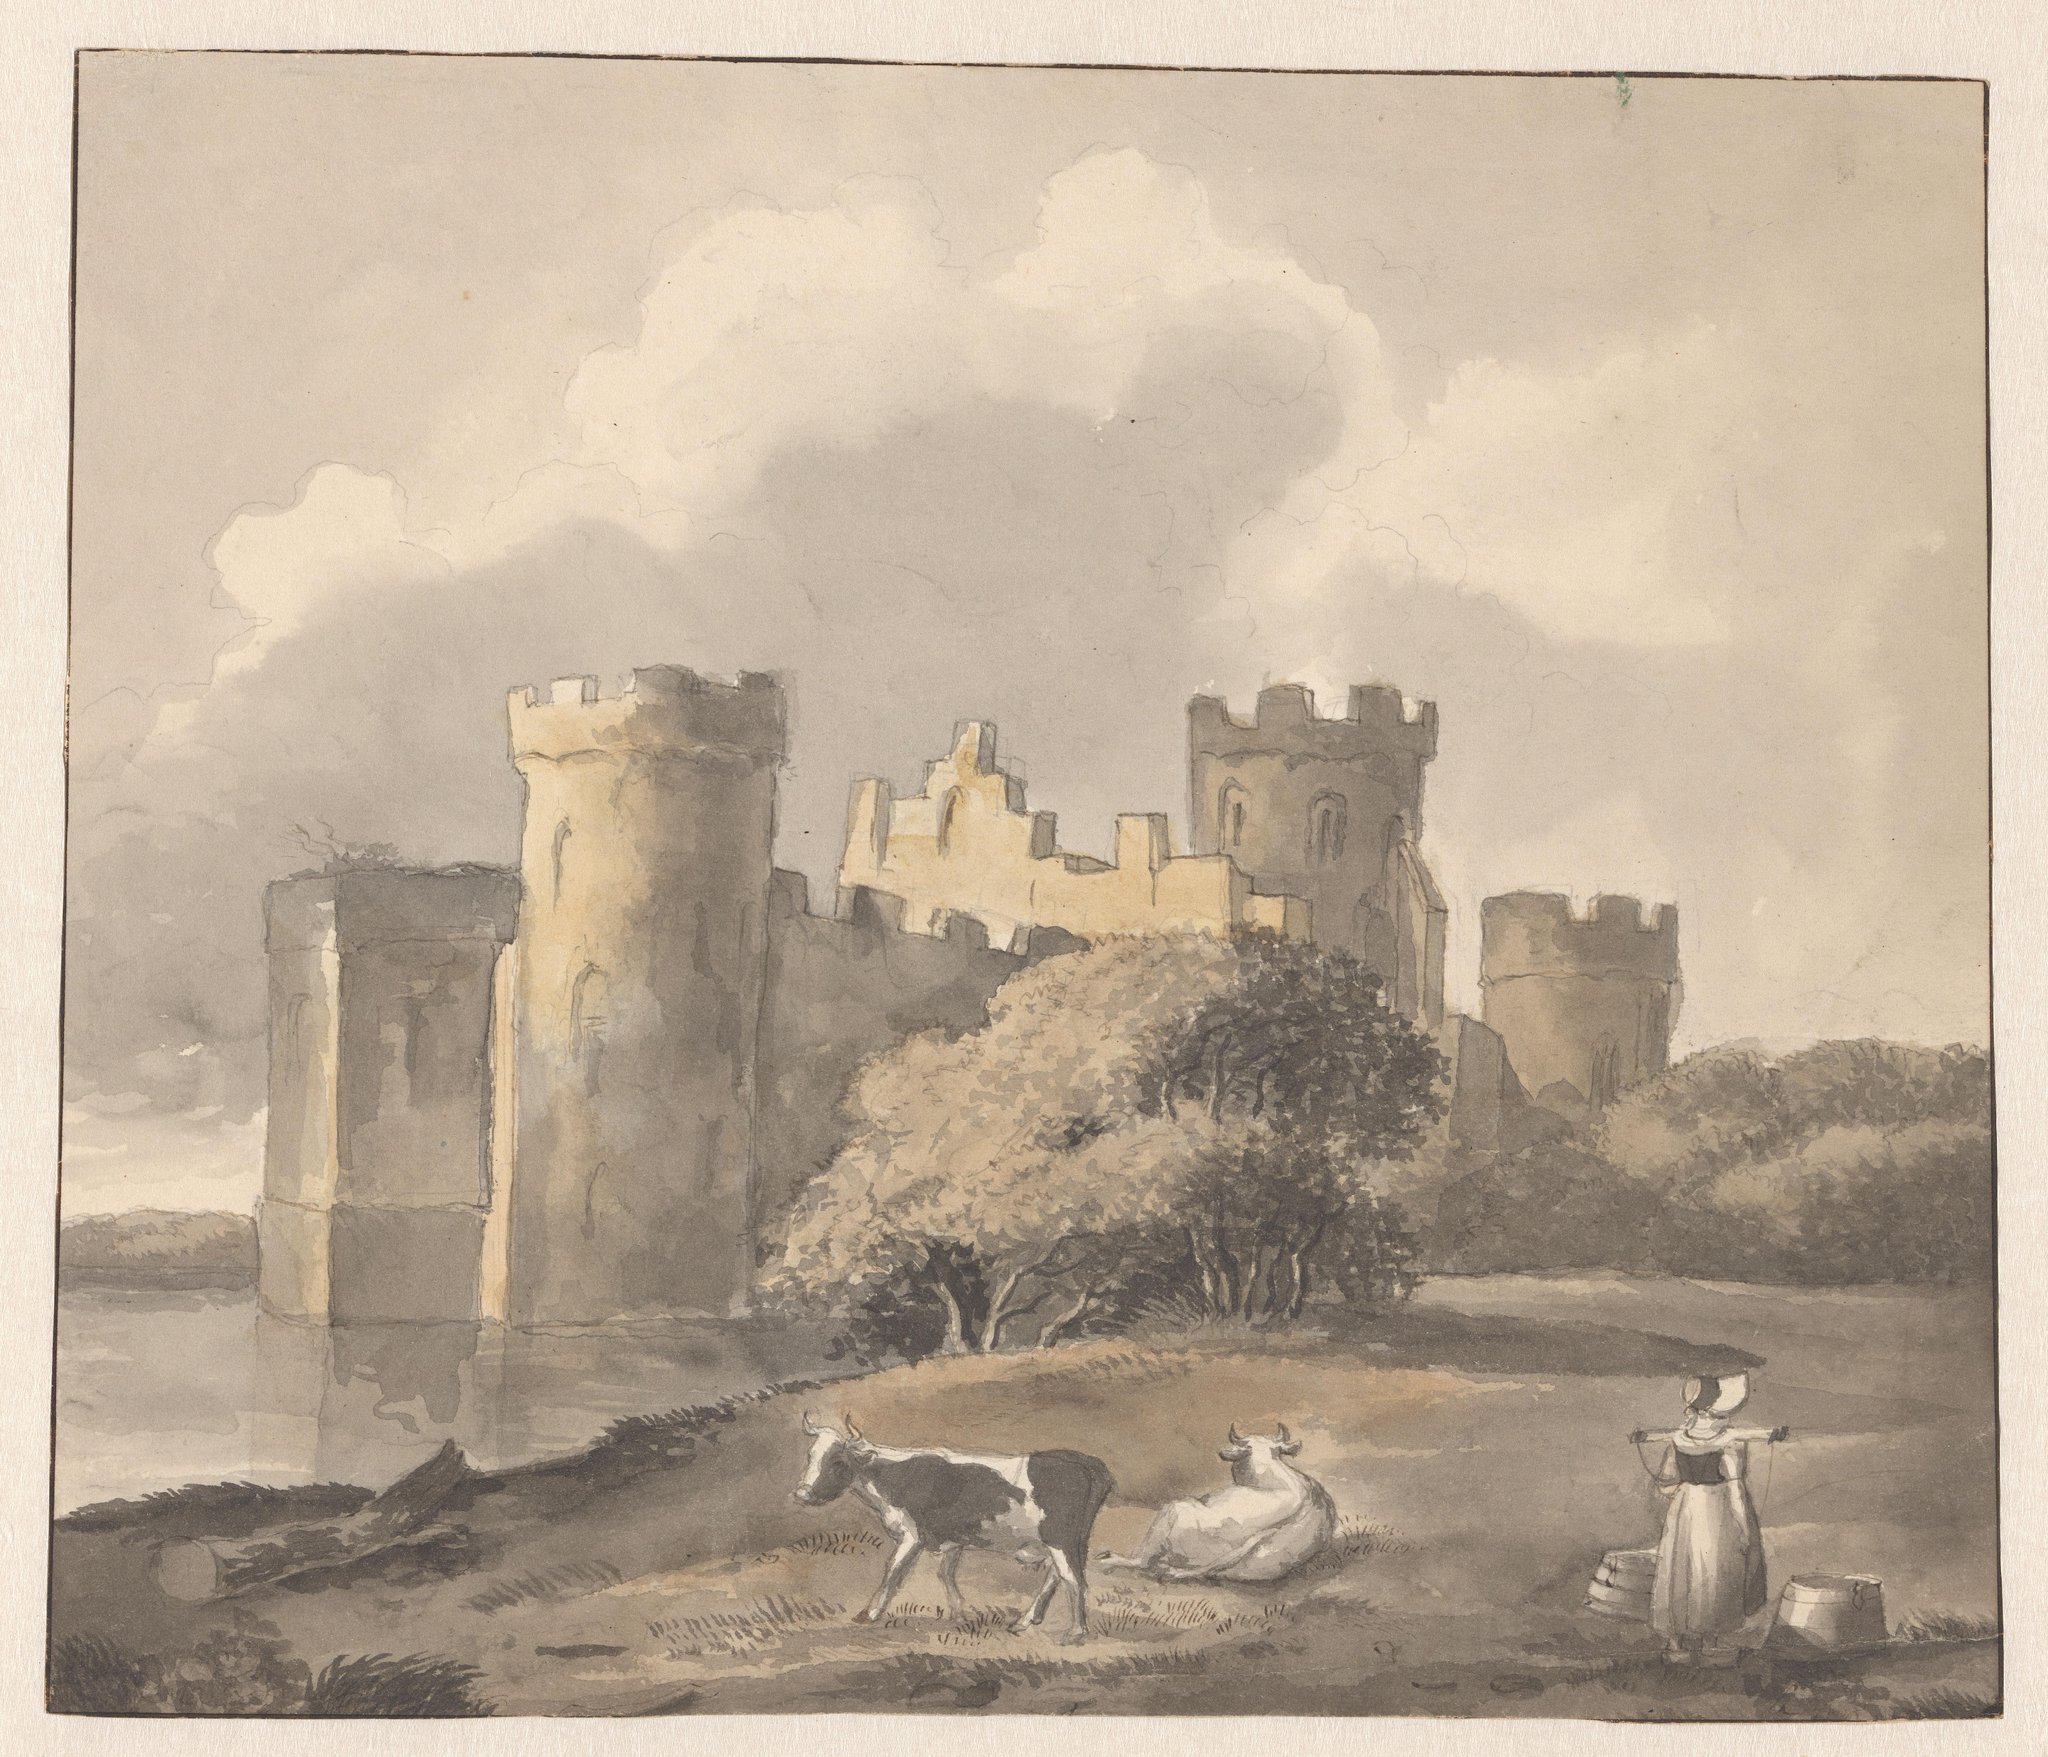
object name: drawing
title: Koeien en een boerin bij een kasteel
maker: joannes carolus alberdingk thijm (jan)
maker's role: pater, schrijver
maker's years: 1847-1926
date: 1853-1860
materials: ink, paper, pencil, watercolor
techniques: brush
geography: netherlands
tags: cow, castle, milkmaid